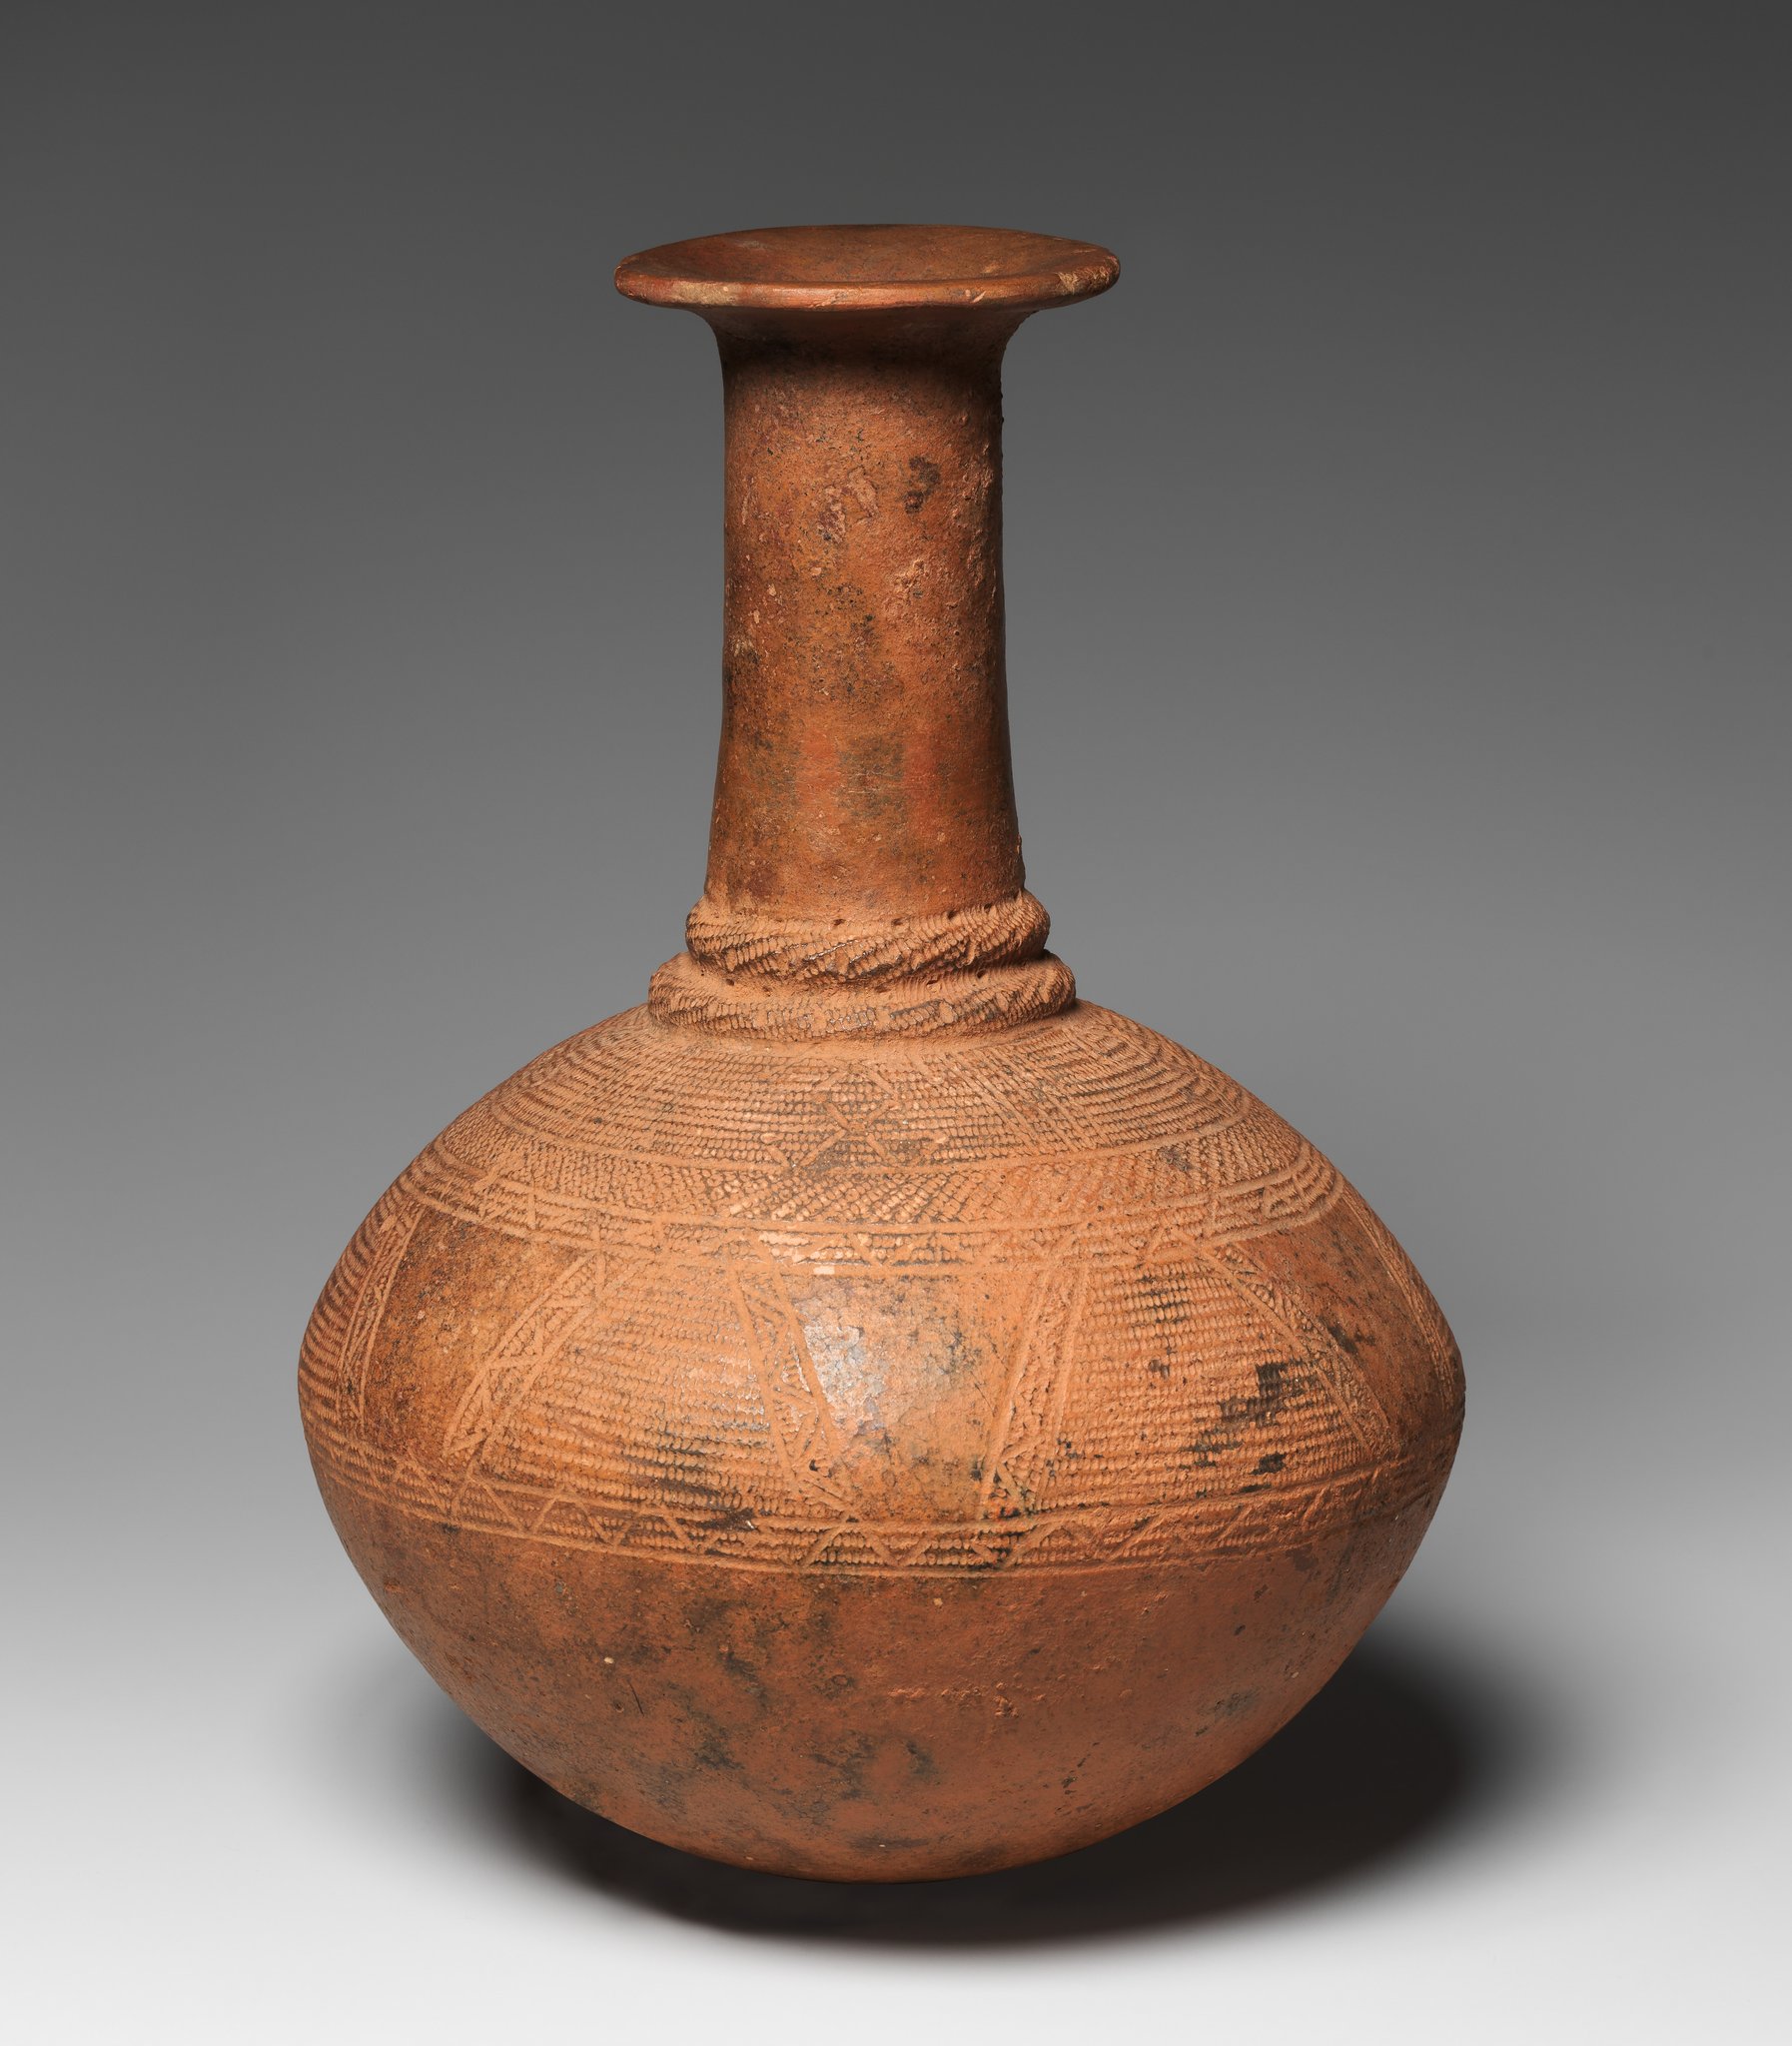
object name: vessel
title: Long-necked vessel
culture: middle niger civilization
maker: middle niger artist(s)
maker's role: artist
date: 1101-1600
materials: terracotta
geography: mali